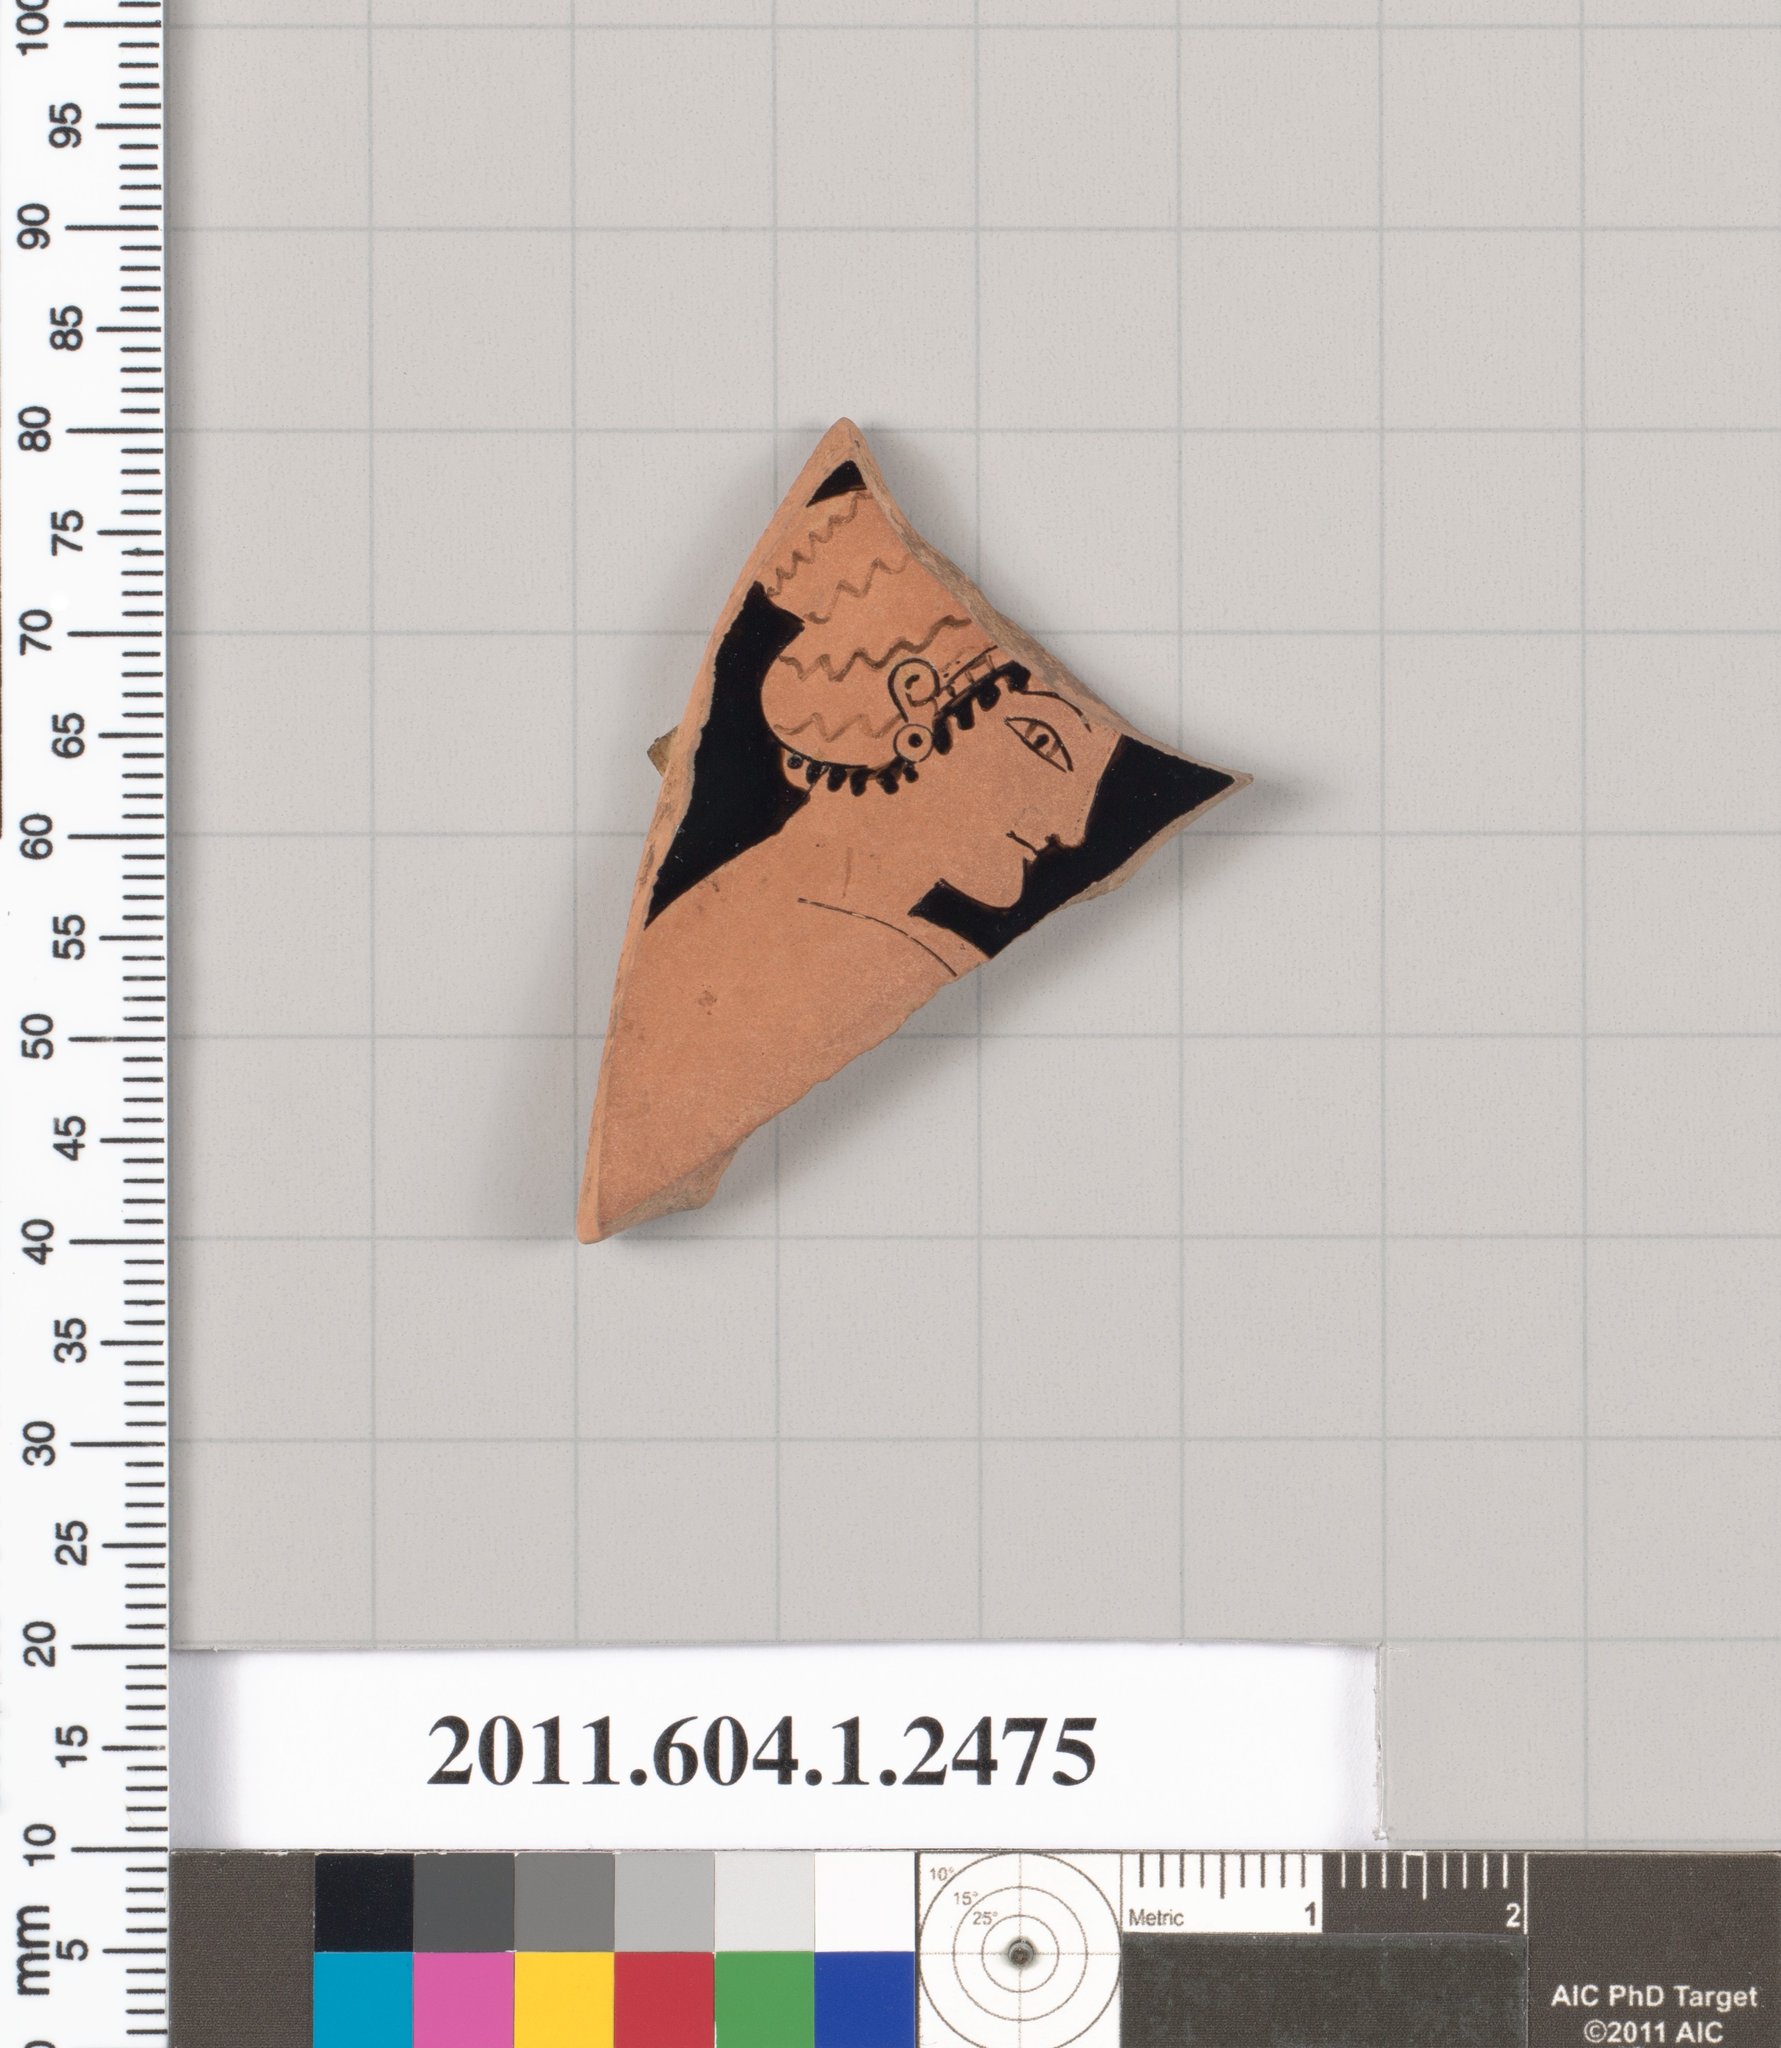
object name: kylix fragment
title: Terracotta fragment of a kylix (drinking cup)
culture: greek, attic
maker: ambrosios painter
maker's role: artist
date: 520-500 BCE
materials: terracotta